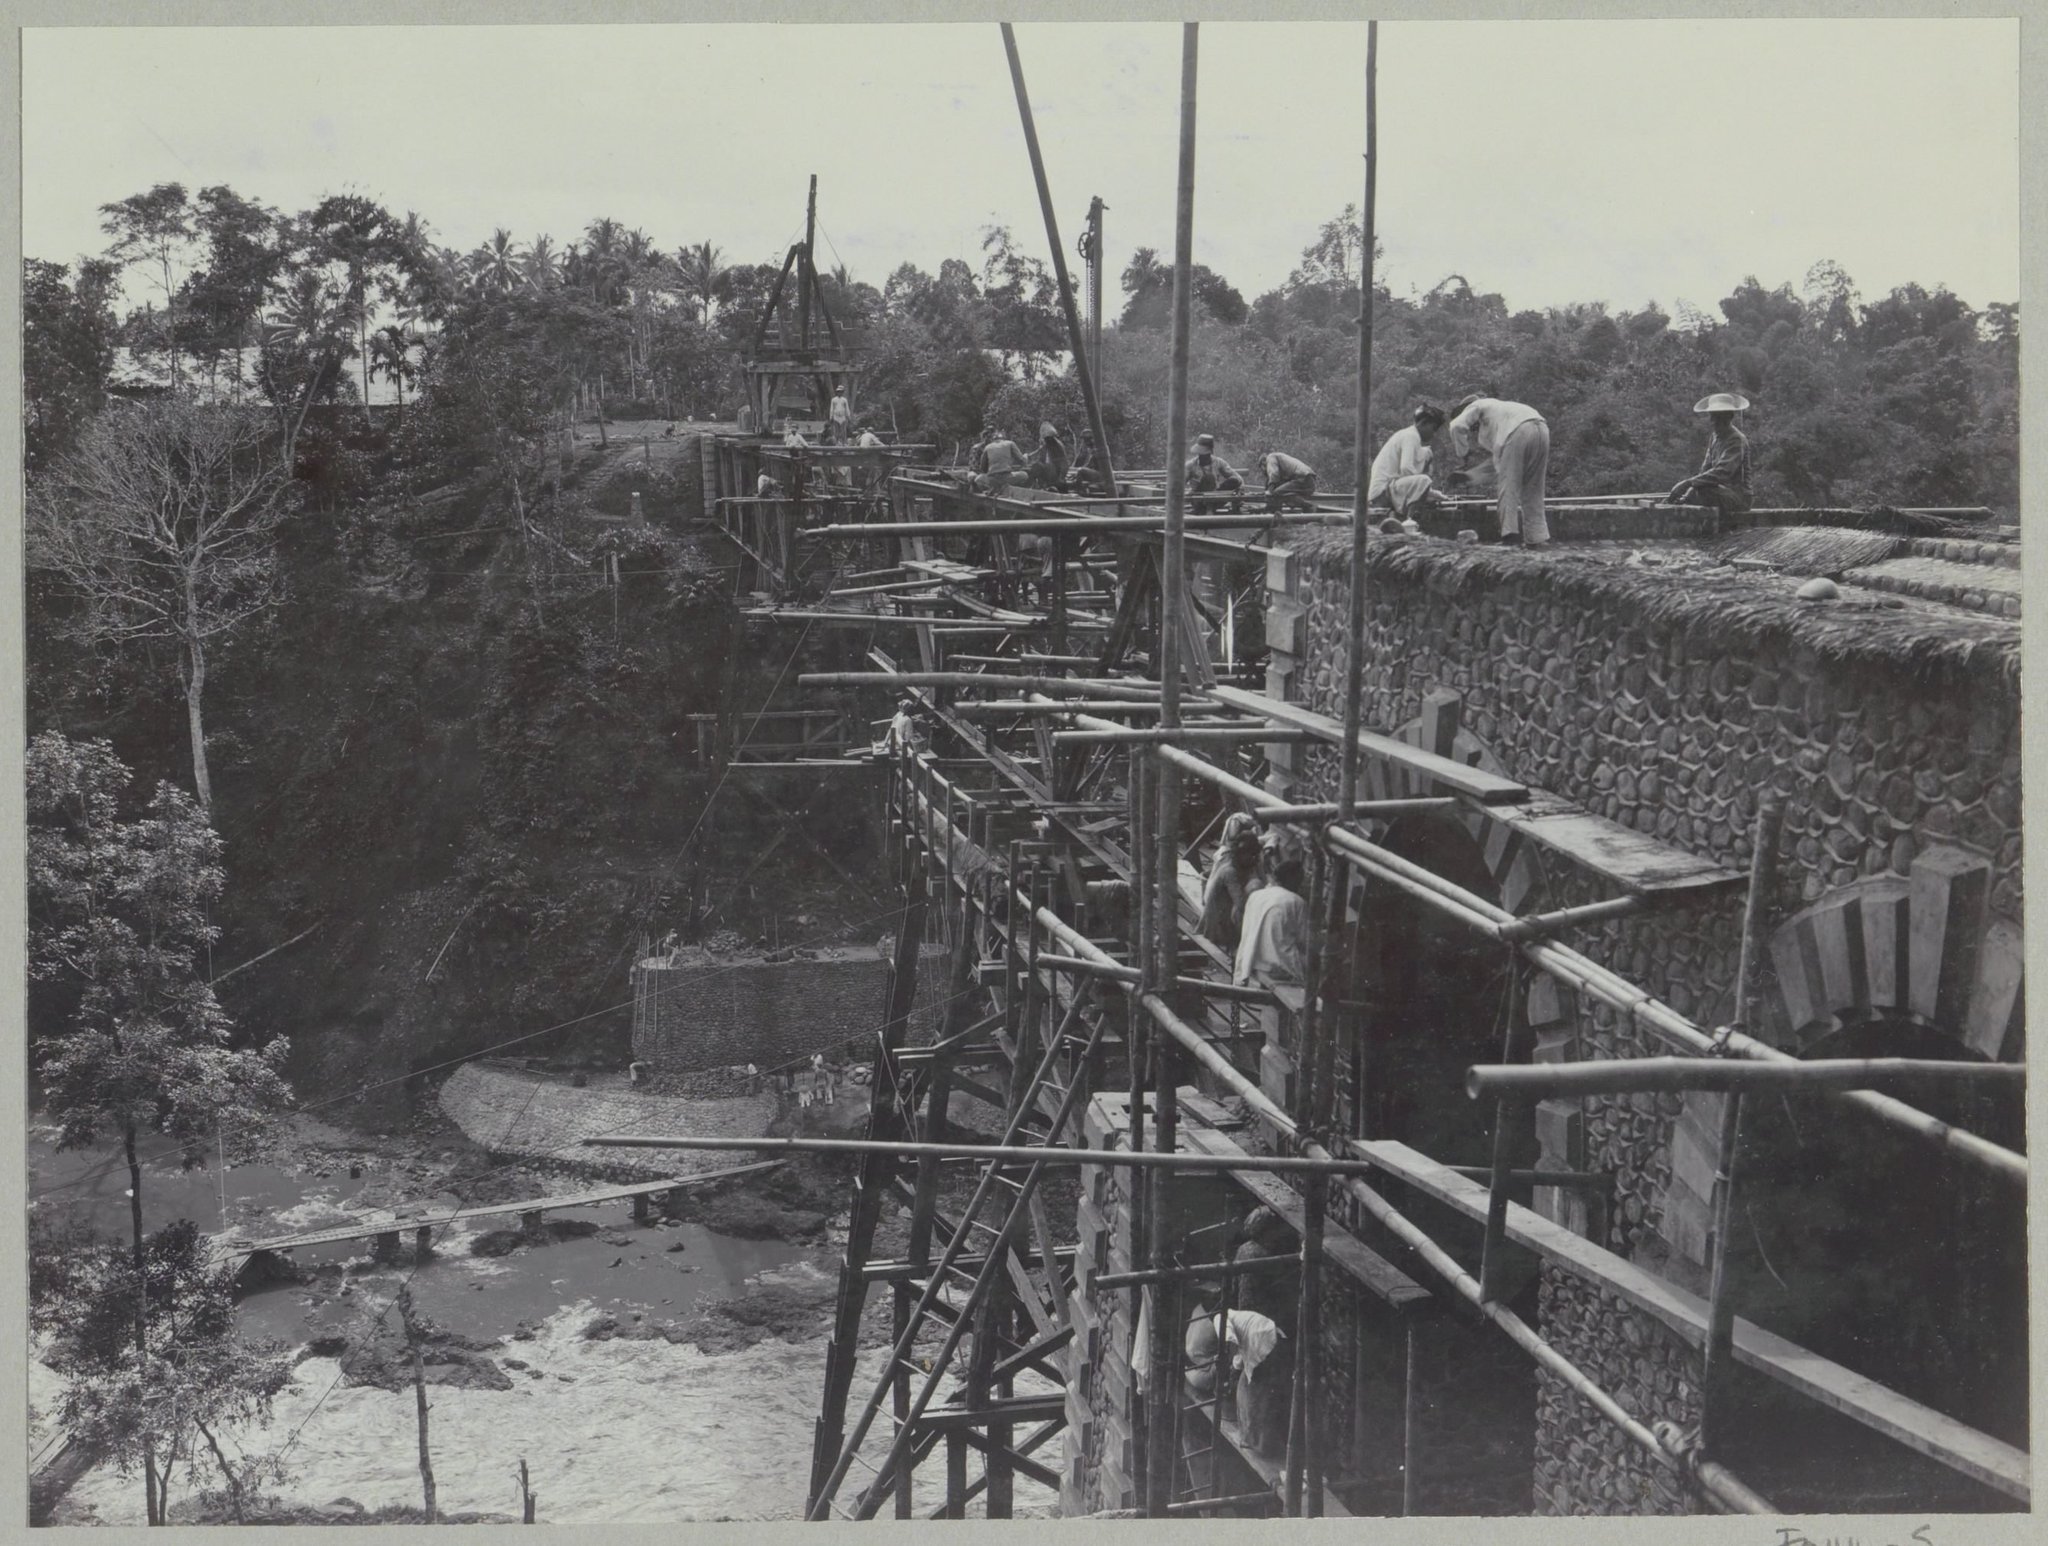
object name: photograph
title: Bouwwerkzaamheden aan het westelijk landhoofd en afbraak van de bok op het oostelijk landhoofd aan de oevers van de Kali Brantas ten zuiden van Malang (Photo XIX)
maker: Anonymous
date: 1890-1920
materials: cardboard, paper, photographic support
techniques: gelatin silver print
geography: java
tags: scaffold (~ building activities), engineering, landscape with bridge, viaduct or aqueduct, bridge, building-site, java, dutch east indies, the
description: Foto met op de linkerpagina het bijbehorende bijschrift. Onderdeel van Fotoalbum met opnames van de bouw van een brug over de Kali Brantas ten zuiden van Malang op Java.